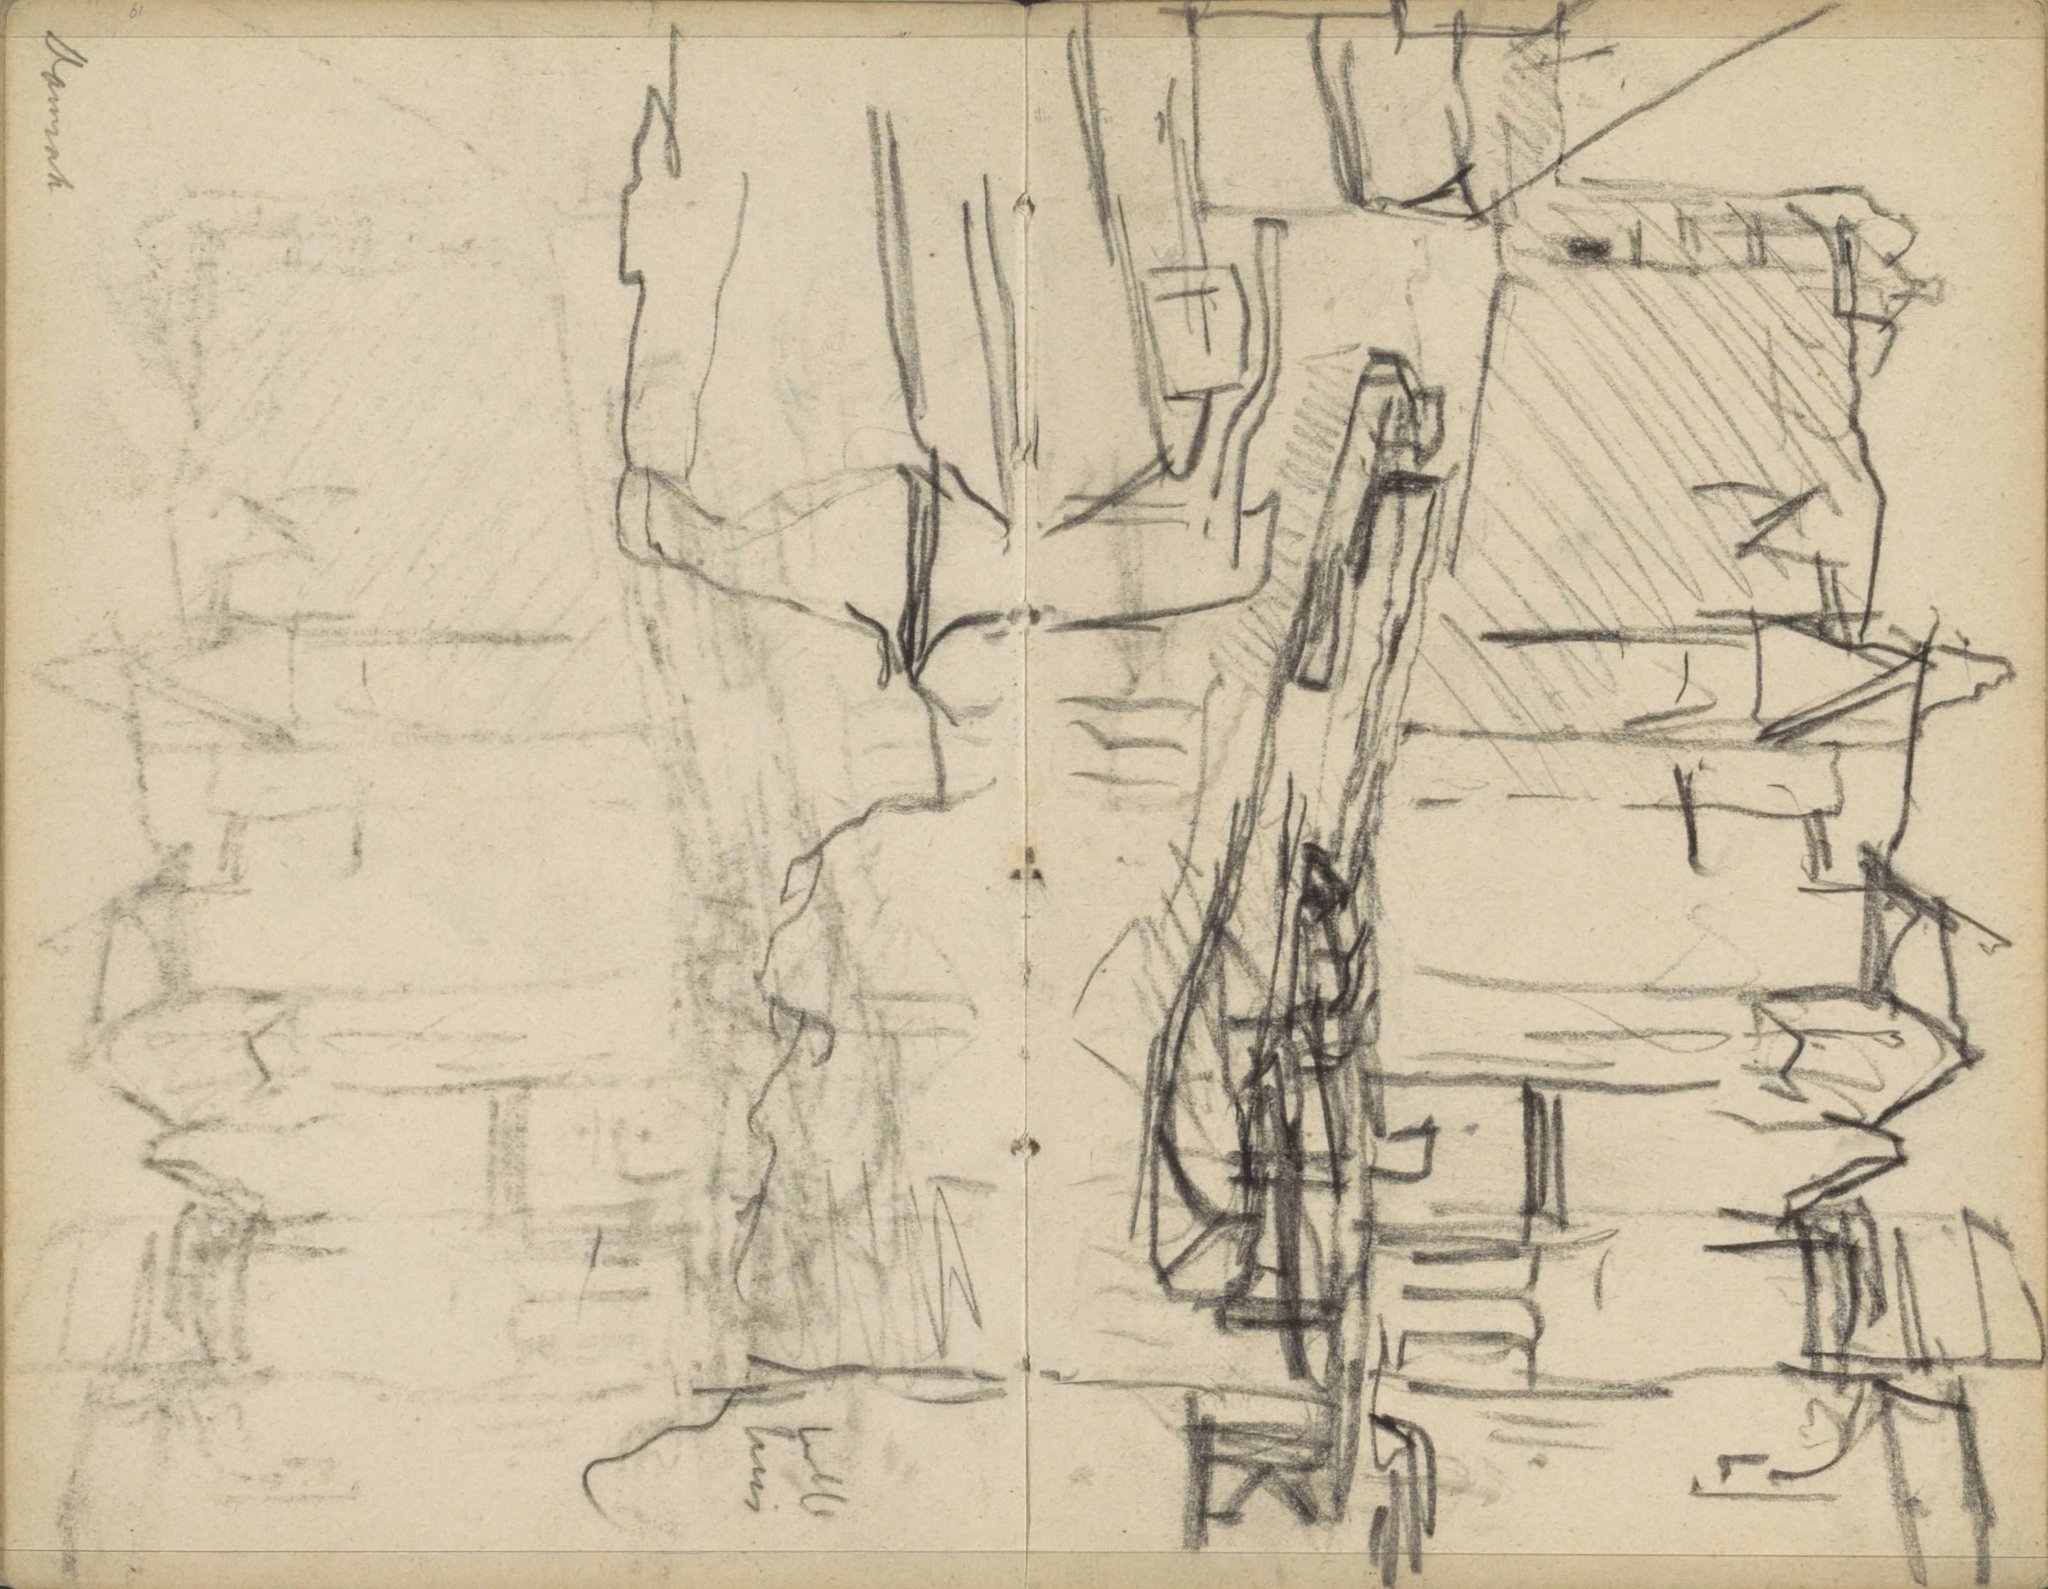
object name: sketchbook leaf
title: Gezicht op boten aan het Damrak te Amsterdam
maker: george hendrik breitner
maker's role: draughtsman, painter, print maker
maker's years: 1857-1923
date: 1903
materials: chalk, paper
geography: amsterdam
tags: urban housing, ships (in general), canals, waters (in city)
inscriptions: annotation: ‘Damrak’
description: Gezicht op boten aan het Damrak te Amsterdam, mogelijk gezien vanaf de Oude Brug. Pagina 61 en pagina 62 uit een schetsboek met 46 bladen vervaardigd te Amsterdam en Haarlem.